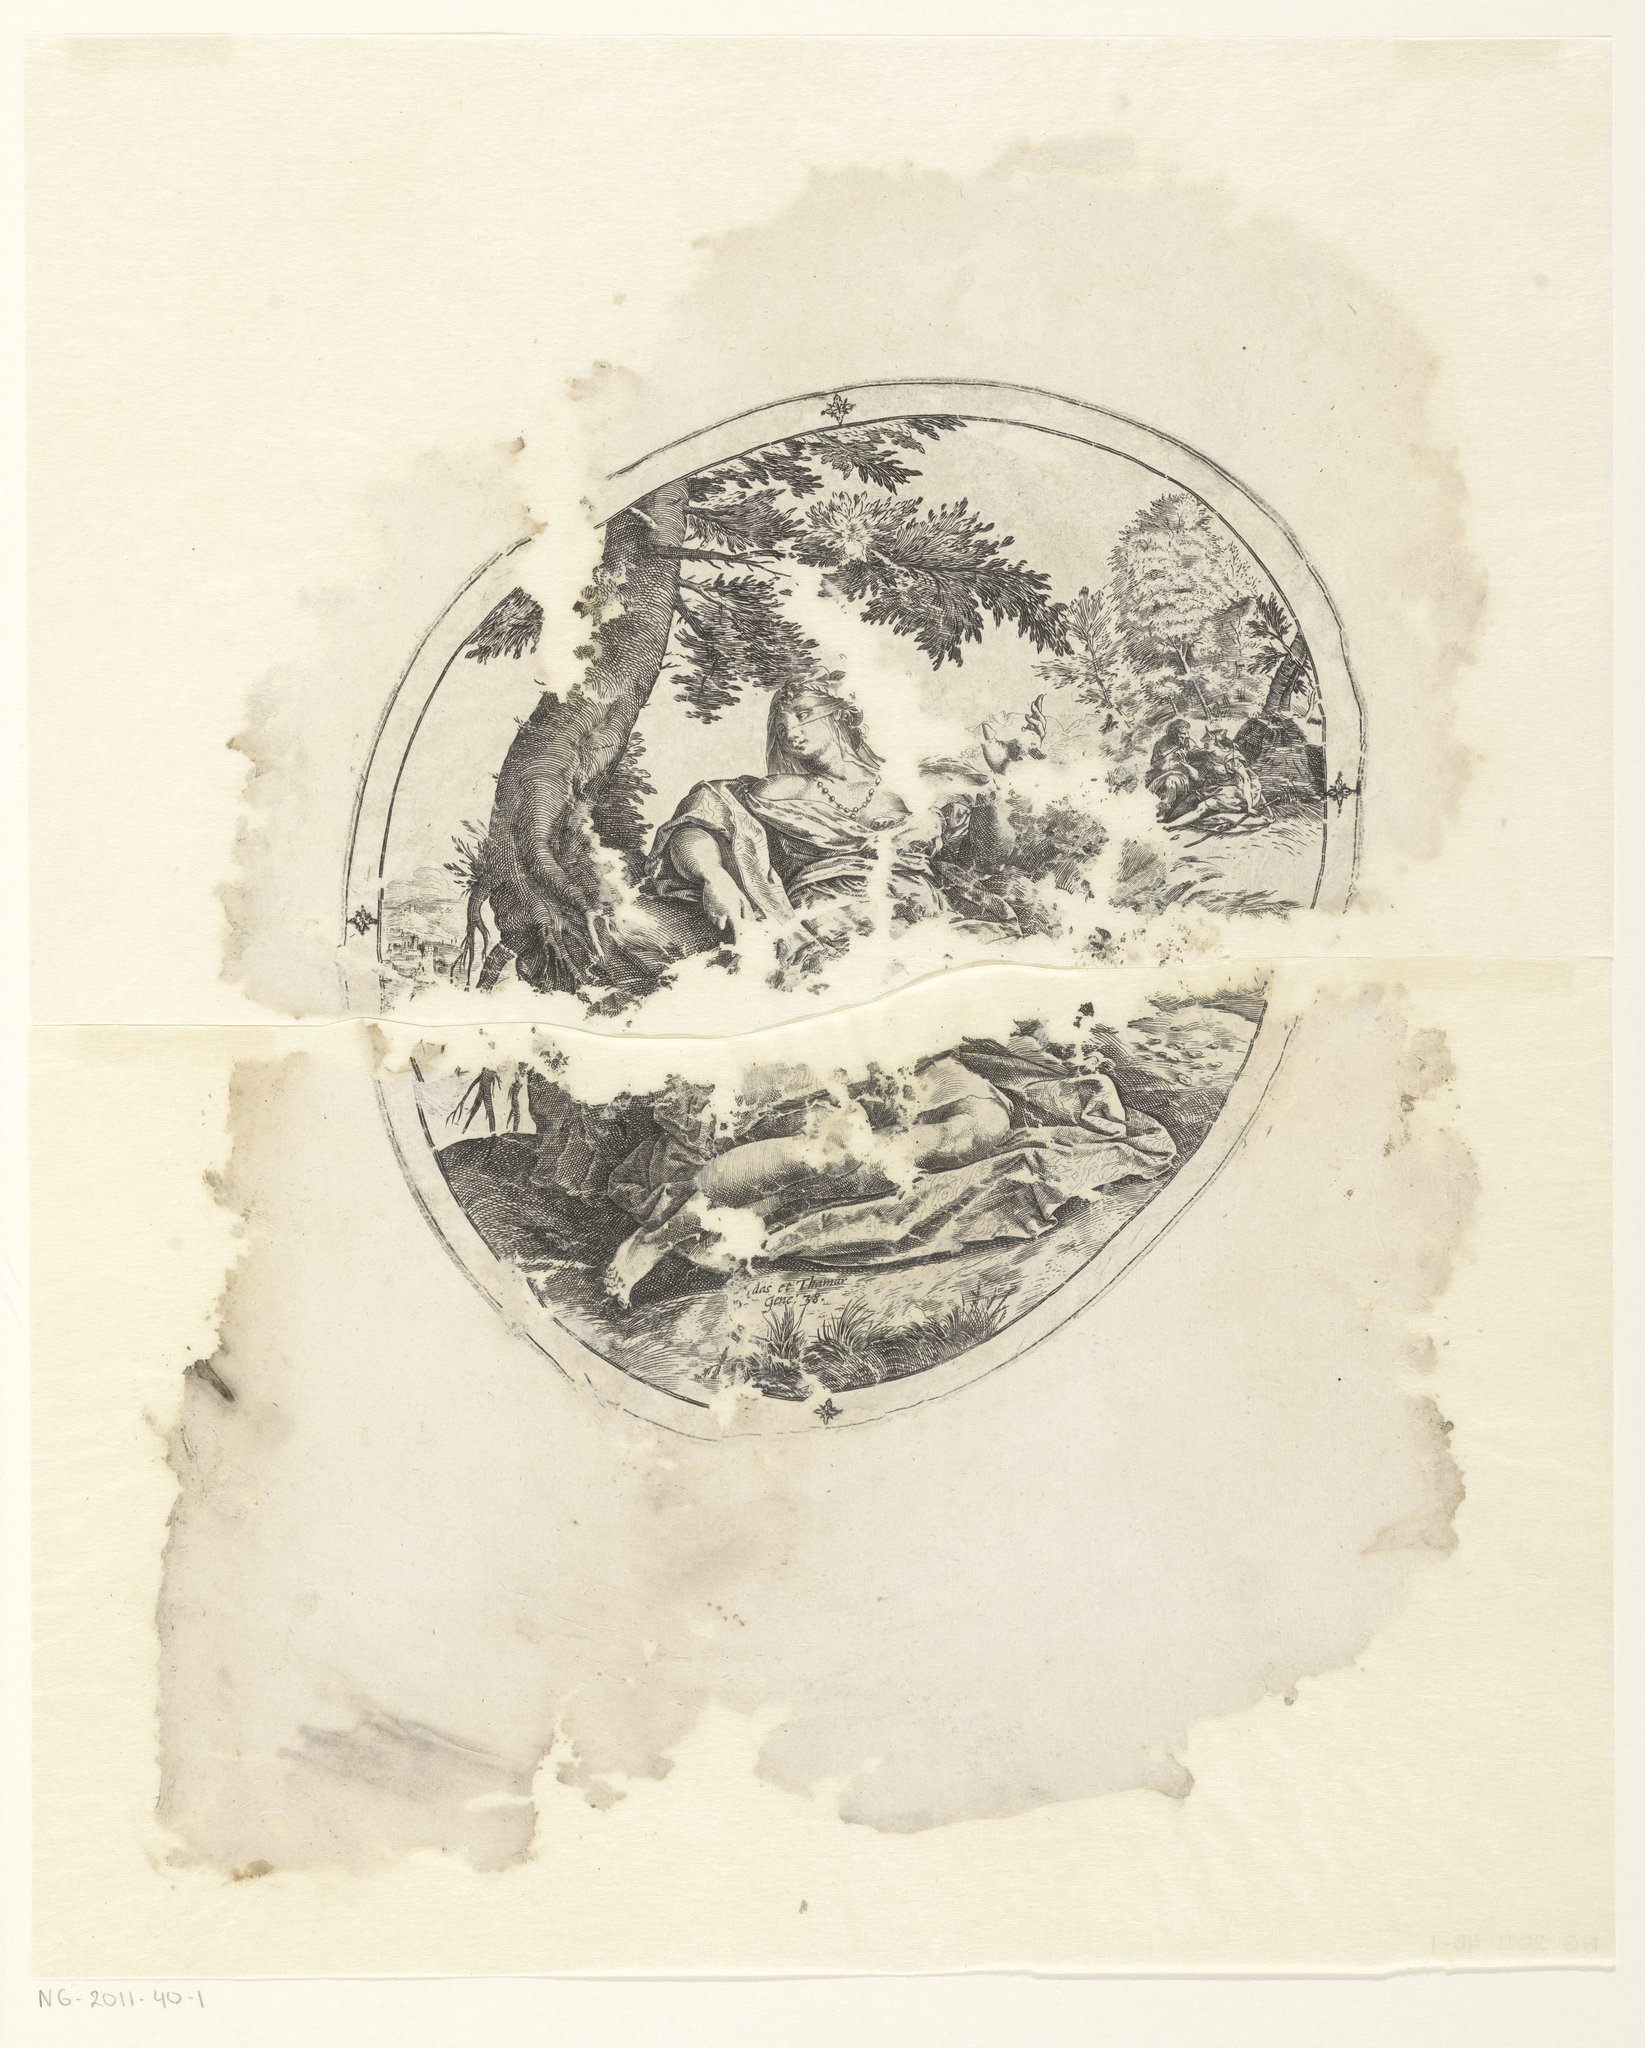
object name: print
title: Juda en Tamar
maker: hendrick goltzius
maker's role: draughtsman, painter, print maker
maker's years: 1558-1617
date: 1580-1596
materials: paper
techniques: engraving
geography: haarlem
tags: story of judah and tamar (genesis 38), tamar changes from her widow's clothes and covers her face with a veil after the manner of the prostitutes; sitting at the entrance of a city on the road to timnath she awaits judah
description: Toeschrijving aan Goltzius door Weigel, verworpen door Hirschmann (en zo ook in TIB en Hol). New Hollstein Dutch beschrijft de prent bij de 'doubtfull attributions'. De prenten in de Nova Zembla collectie zijn tijdens een expeditie van Willem Barendsz en Jacob van Heemskerk in 1596-1597 noodgedwongen in het winterkamp, het ‘Behouden Huis’, op het eiland achtergelaten. De prenten waren in één of meerdere stapels als handelswaar meegenomen vanuit Amsterdam. Bijna drie eeuwen later, in 1871, keerde de Noor Elling Carlsen terug naar Nova Zembla en vond daar de restanten van het ‘Behouden Huis, inclusief een groot deel van de inventaris. Een deel van de prenten, in de vorm van aaneengekoekte kluiten, werd toen ook teruggevonden. De papierkluiten waren soms op meerdere plekken gebroken. Tussen 1975-1979 zijn de prenten van elkaar gescheiden. Dit leverde in totaal ca. 1000 fragmenten van ca. 400 afdrukken van ca. 150 verschillende prenten op. Voor zover mogelijk zijn de fragmenten samengevoegd en zijn de prenten gereconstrueerd.